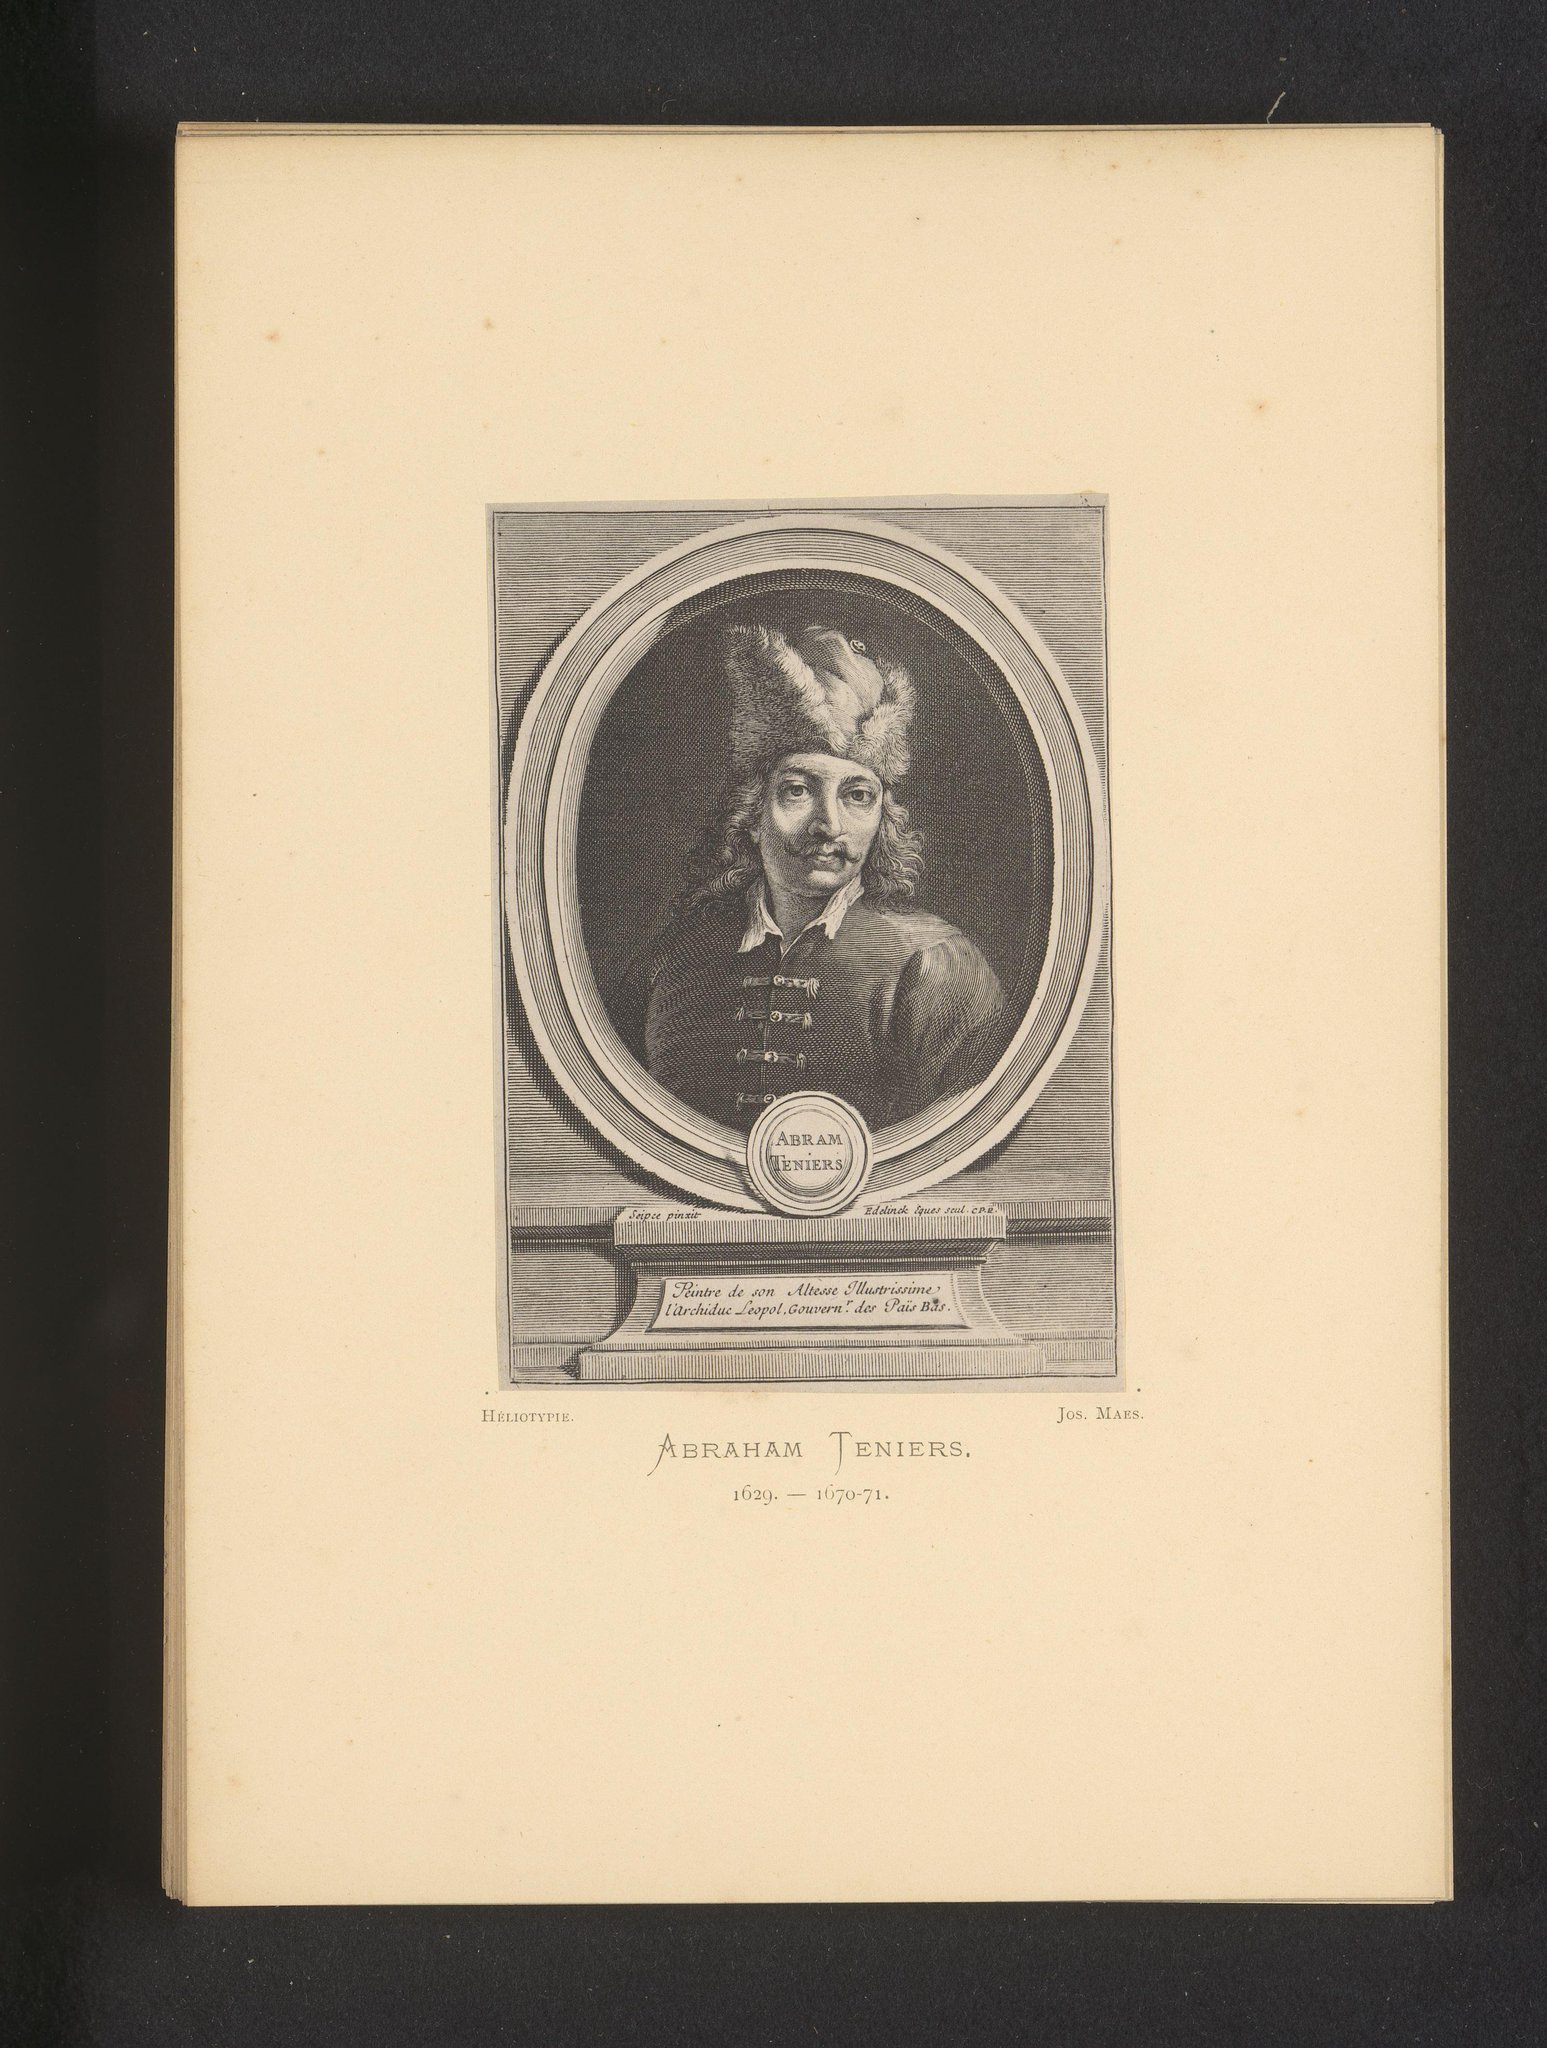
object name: photomechanical print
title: Reproductie van een gravure van een portret van Abraham Teniers door Gerard Edelinck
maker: joseph maes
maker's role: fotograaf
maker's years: 1838-1908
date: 1872-1877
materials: cardboard, paper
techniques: photograph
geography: antwerp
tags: antwerp, publisher, abraham teniers, historical persons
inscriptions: inscription: ‘1629. - 1670-71.’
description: Deze prent maakt deel uit van een omslag met 150 prenten en een katern met een lijst van afbeeldingen.